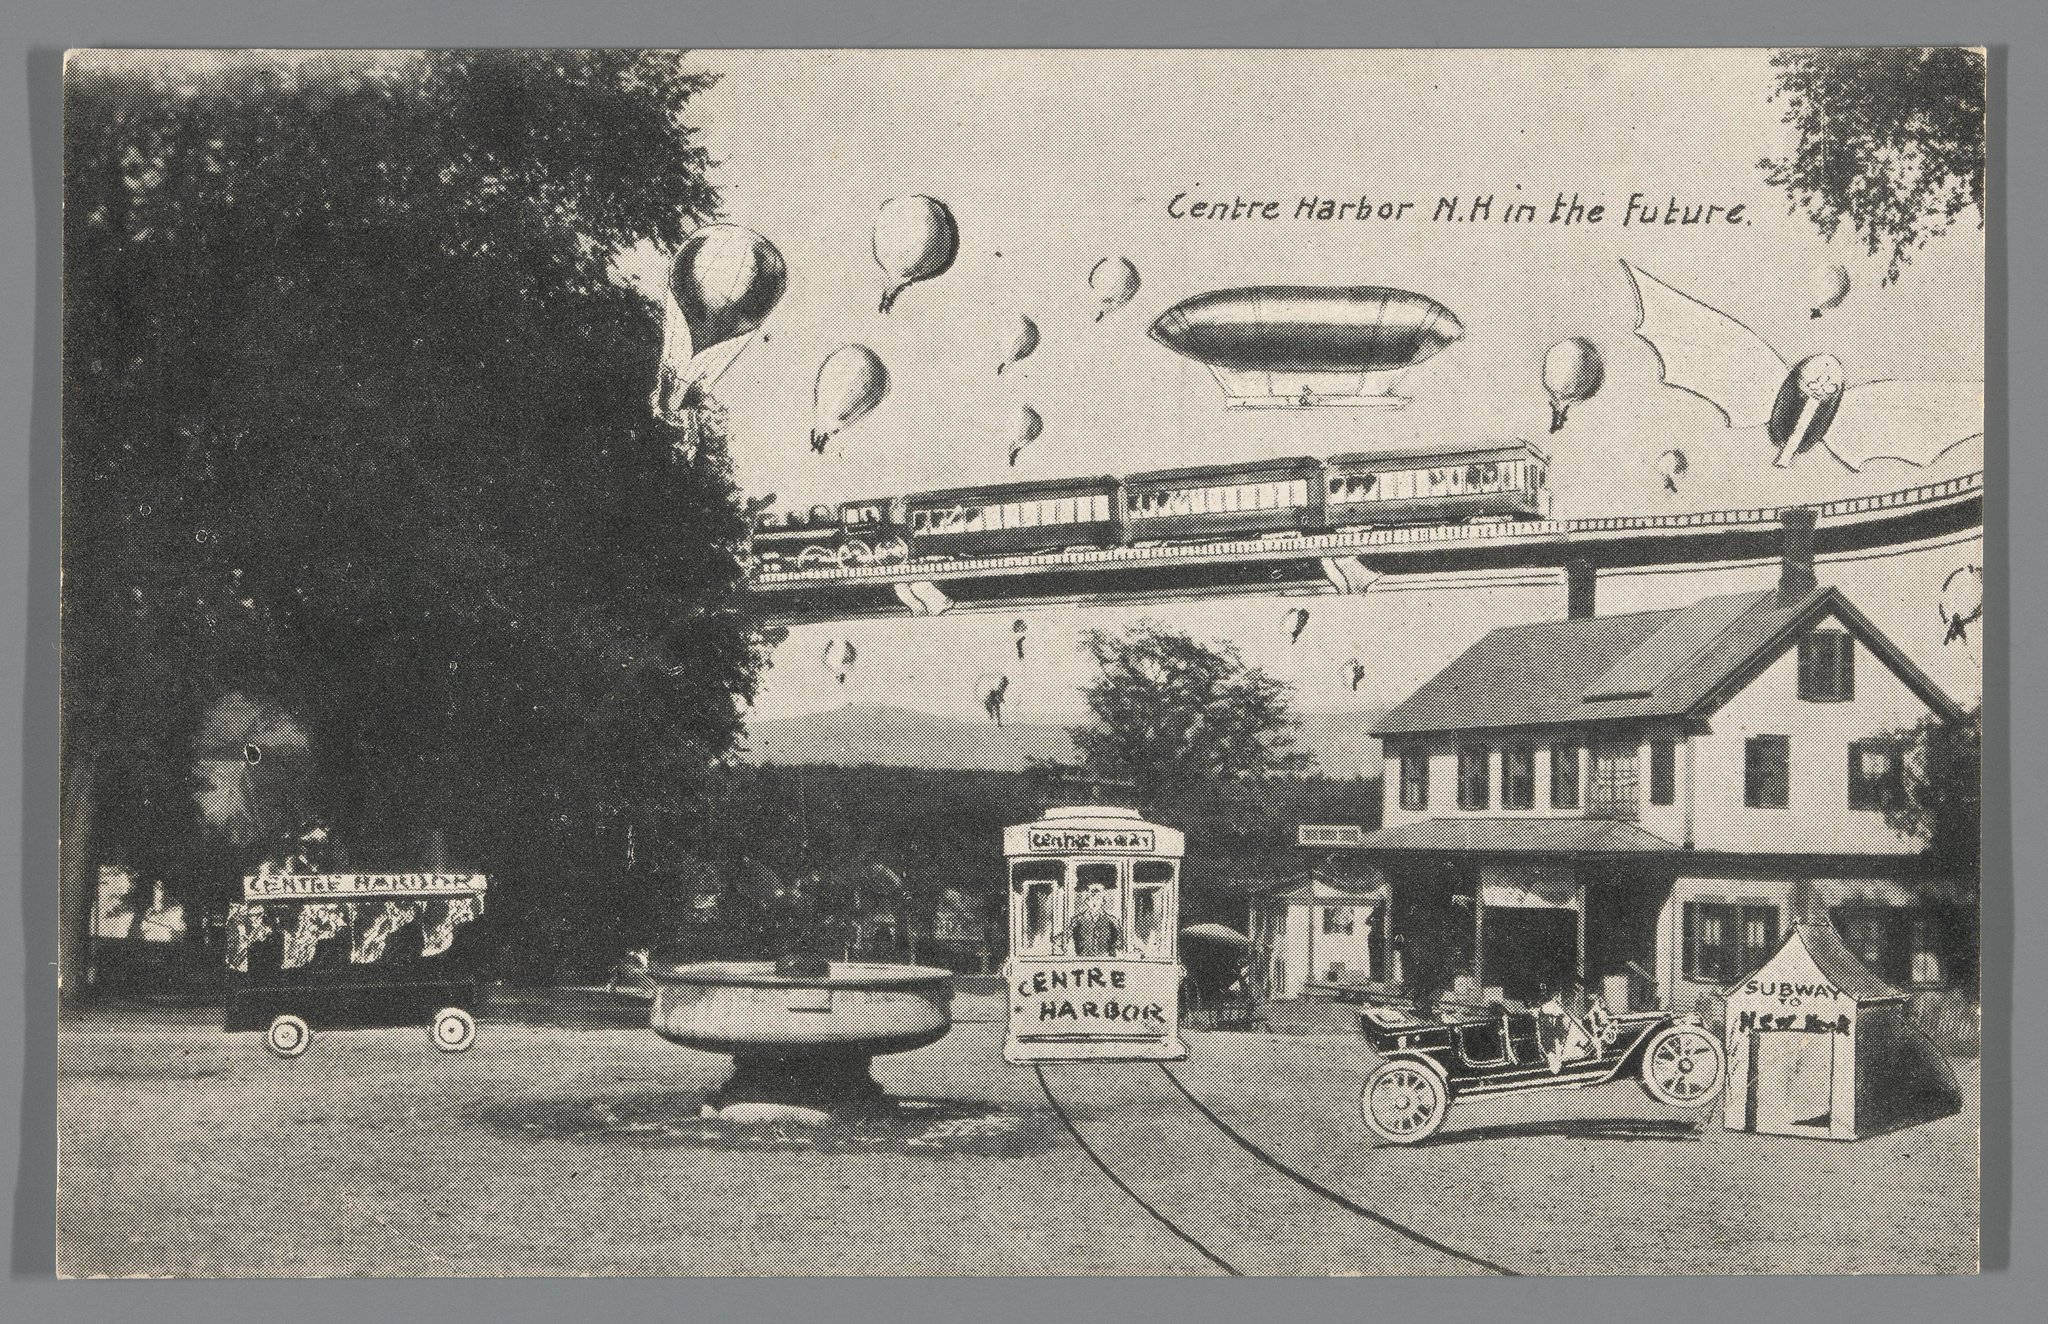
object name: ansichtkaart, prentbriefkaart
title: City of the Future (Centre Harbor, NH)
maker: Anonymous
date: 1910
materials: ink, paper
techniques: autotype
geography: united states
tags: new hampshire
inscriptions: inscription: ‘Centre Harbor N.H. in the Future’